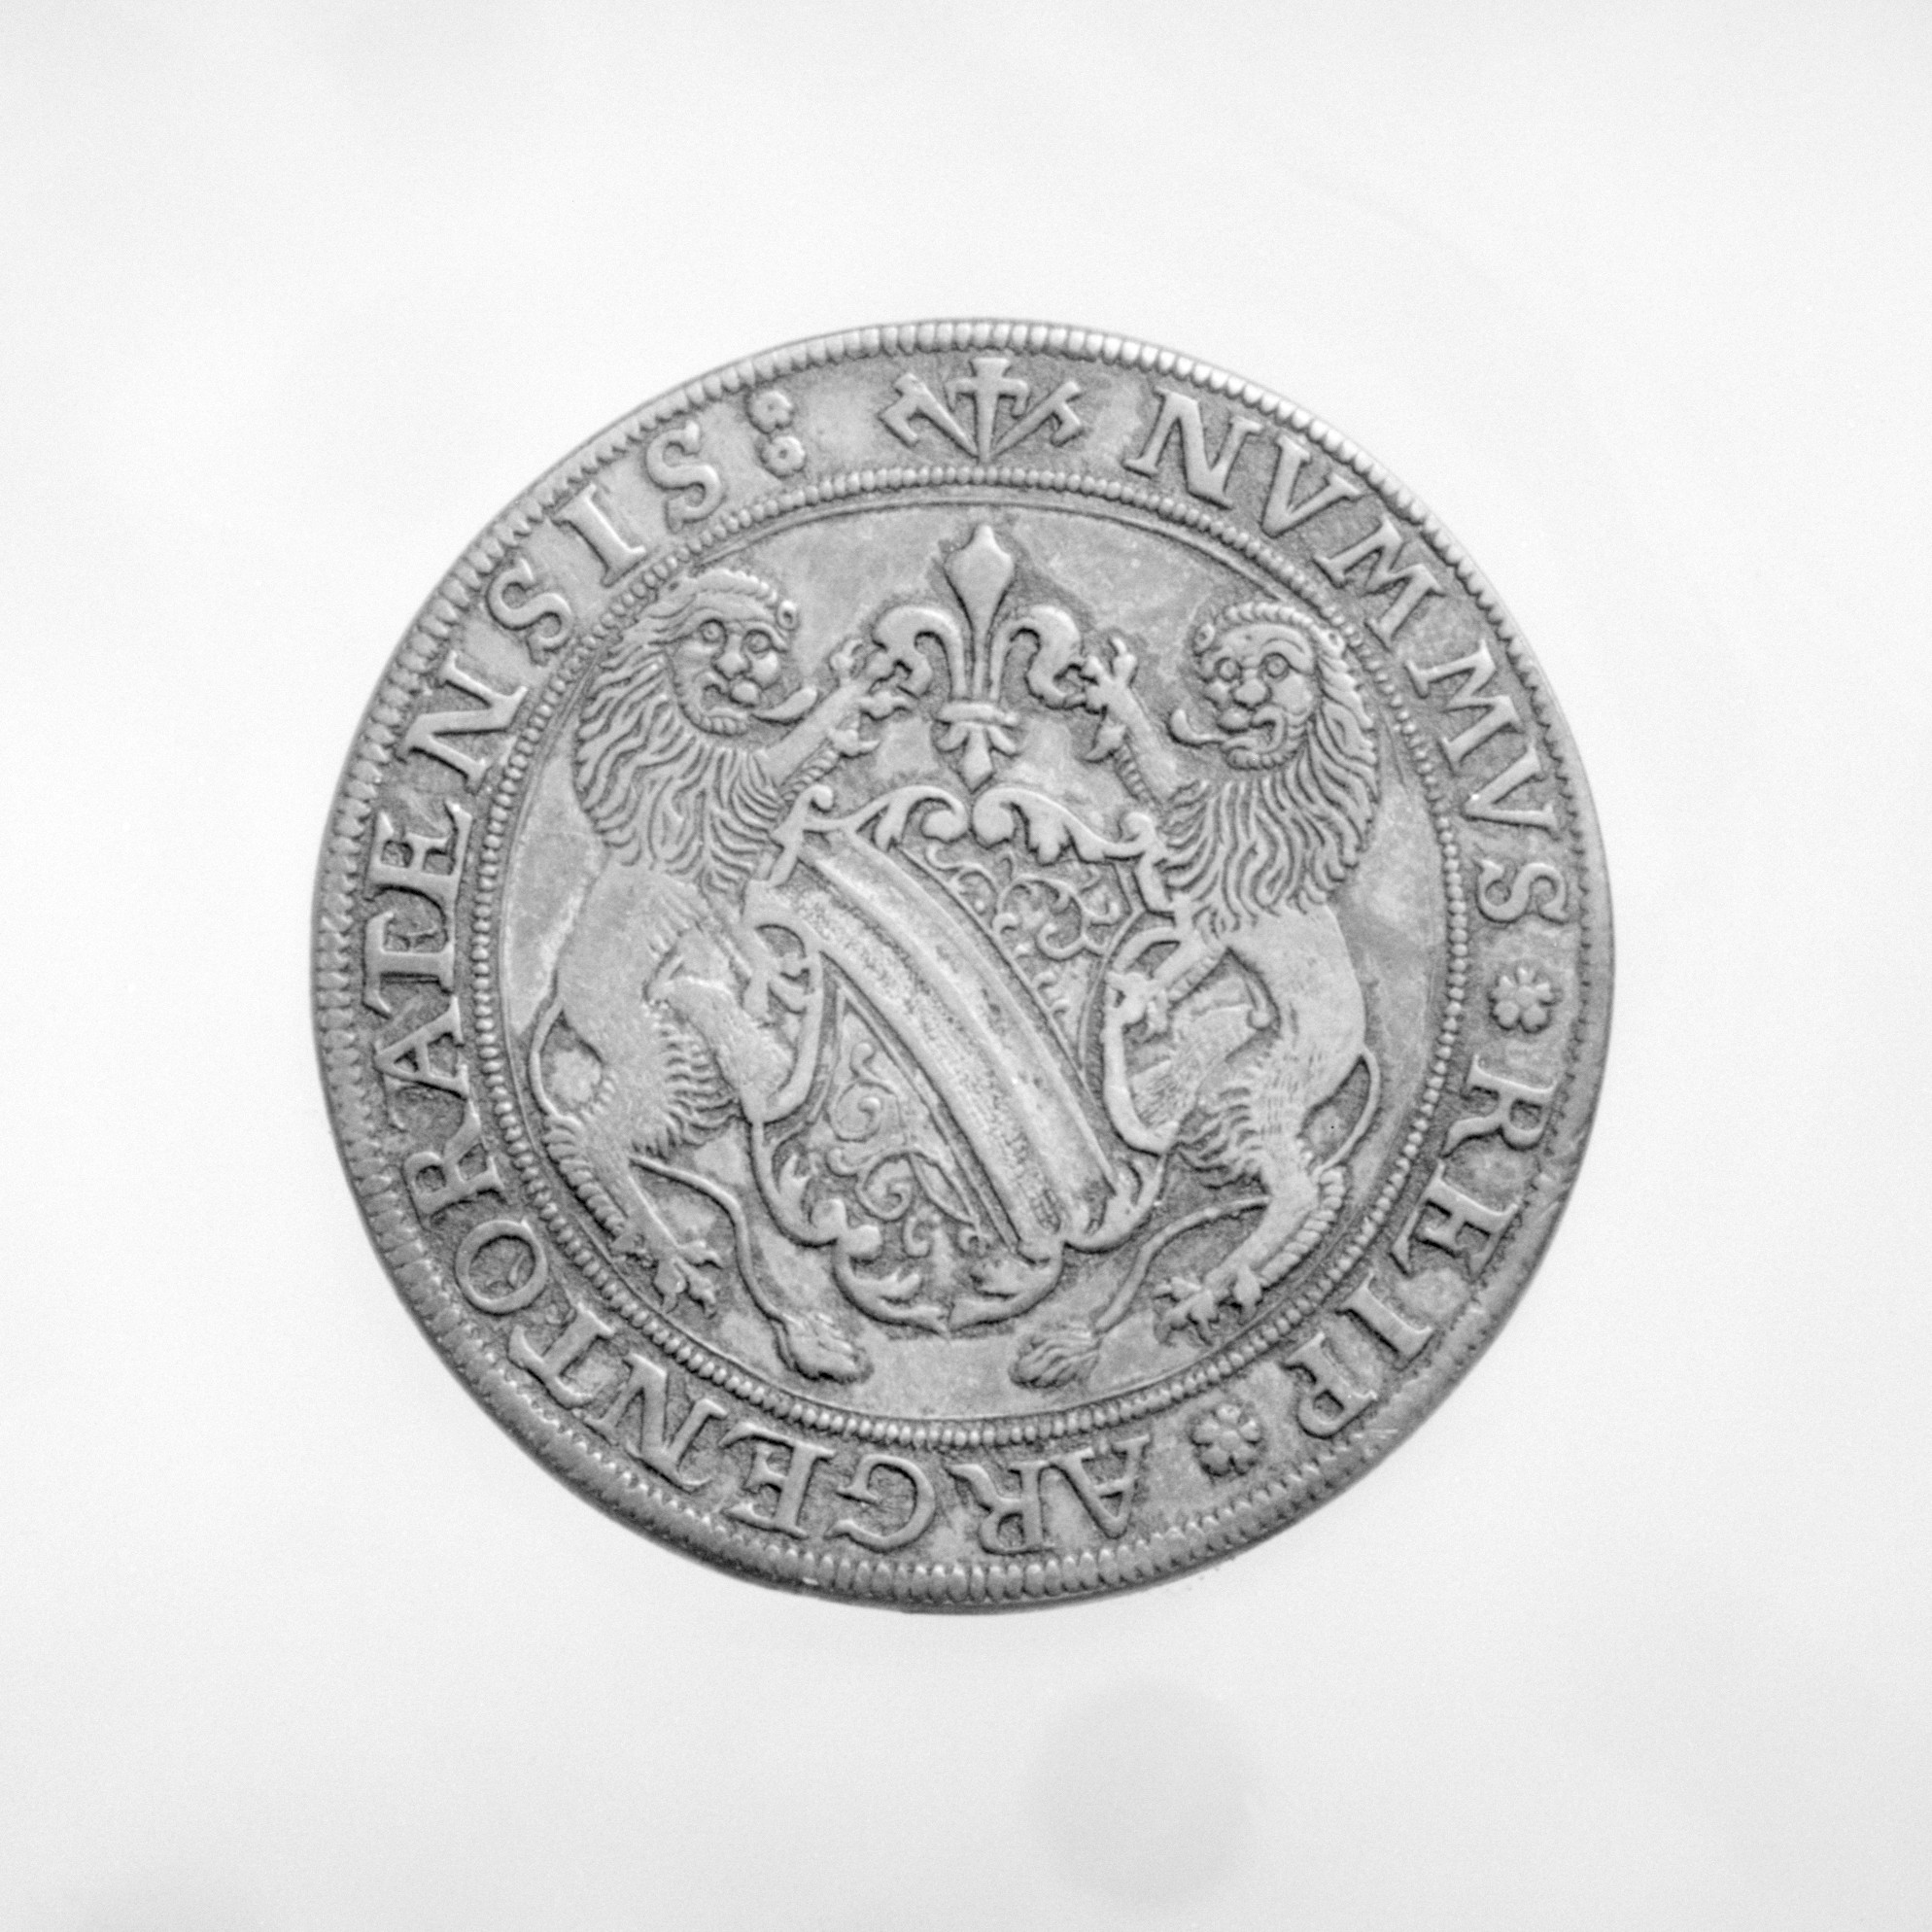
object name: lily dollar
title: Lily-dollar ("Lilienthaler") of the Imperial Free-City of Strasbourg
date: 1567-1600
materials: silver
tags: coat of arms